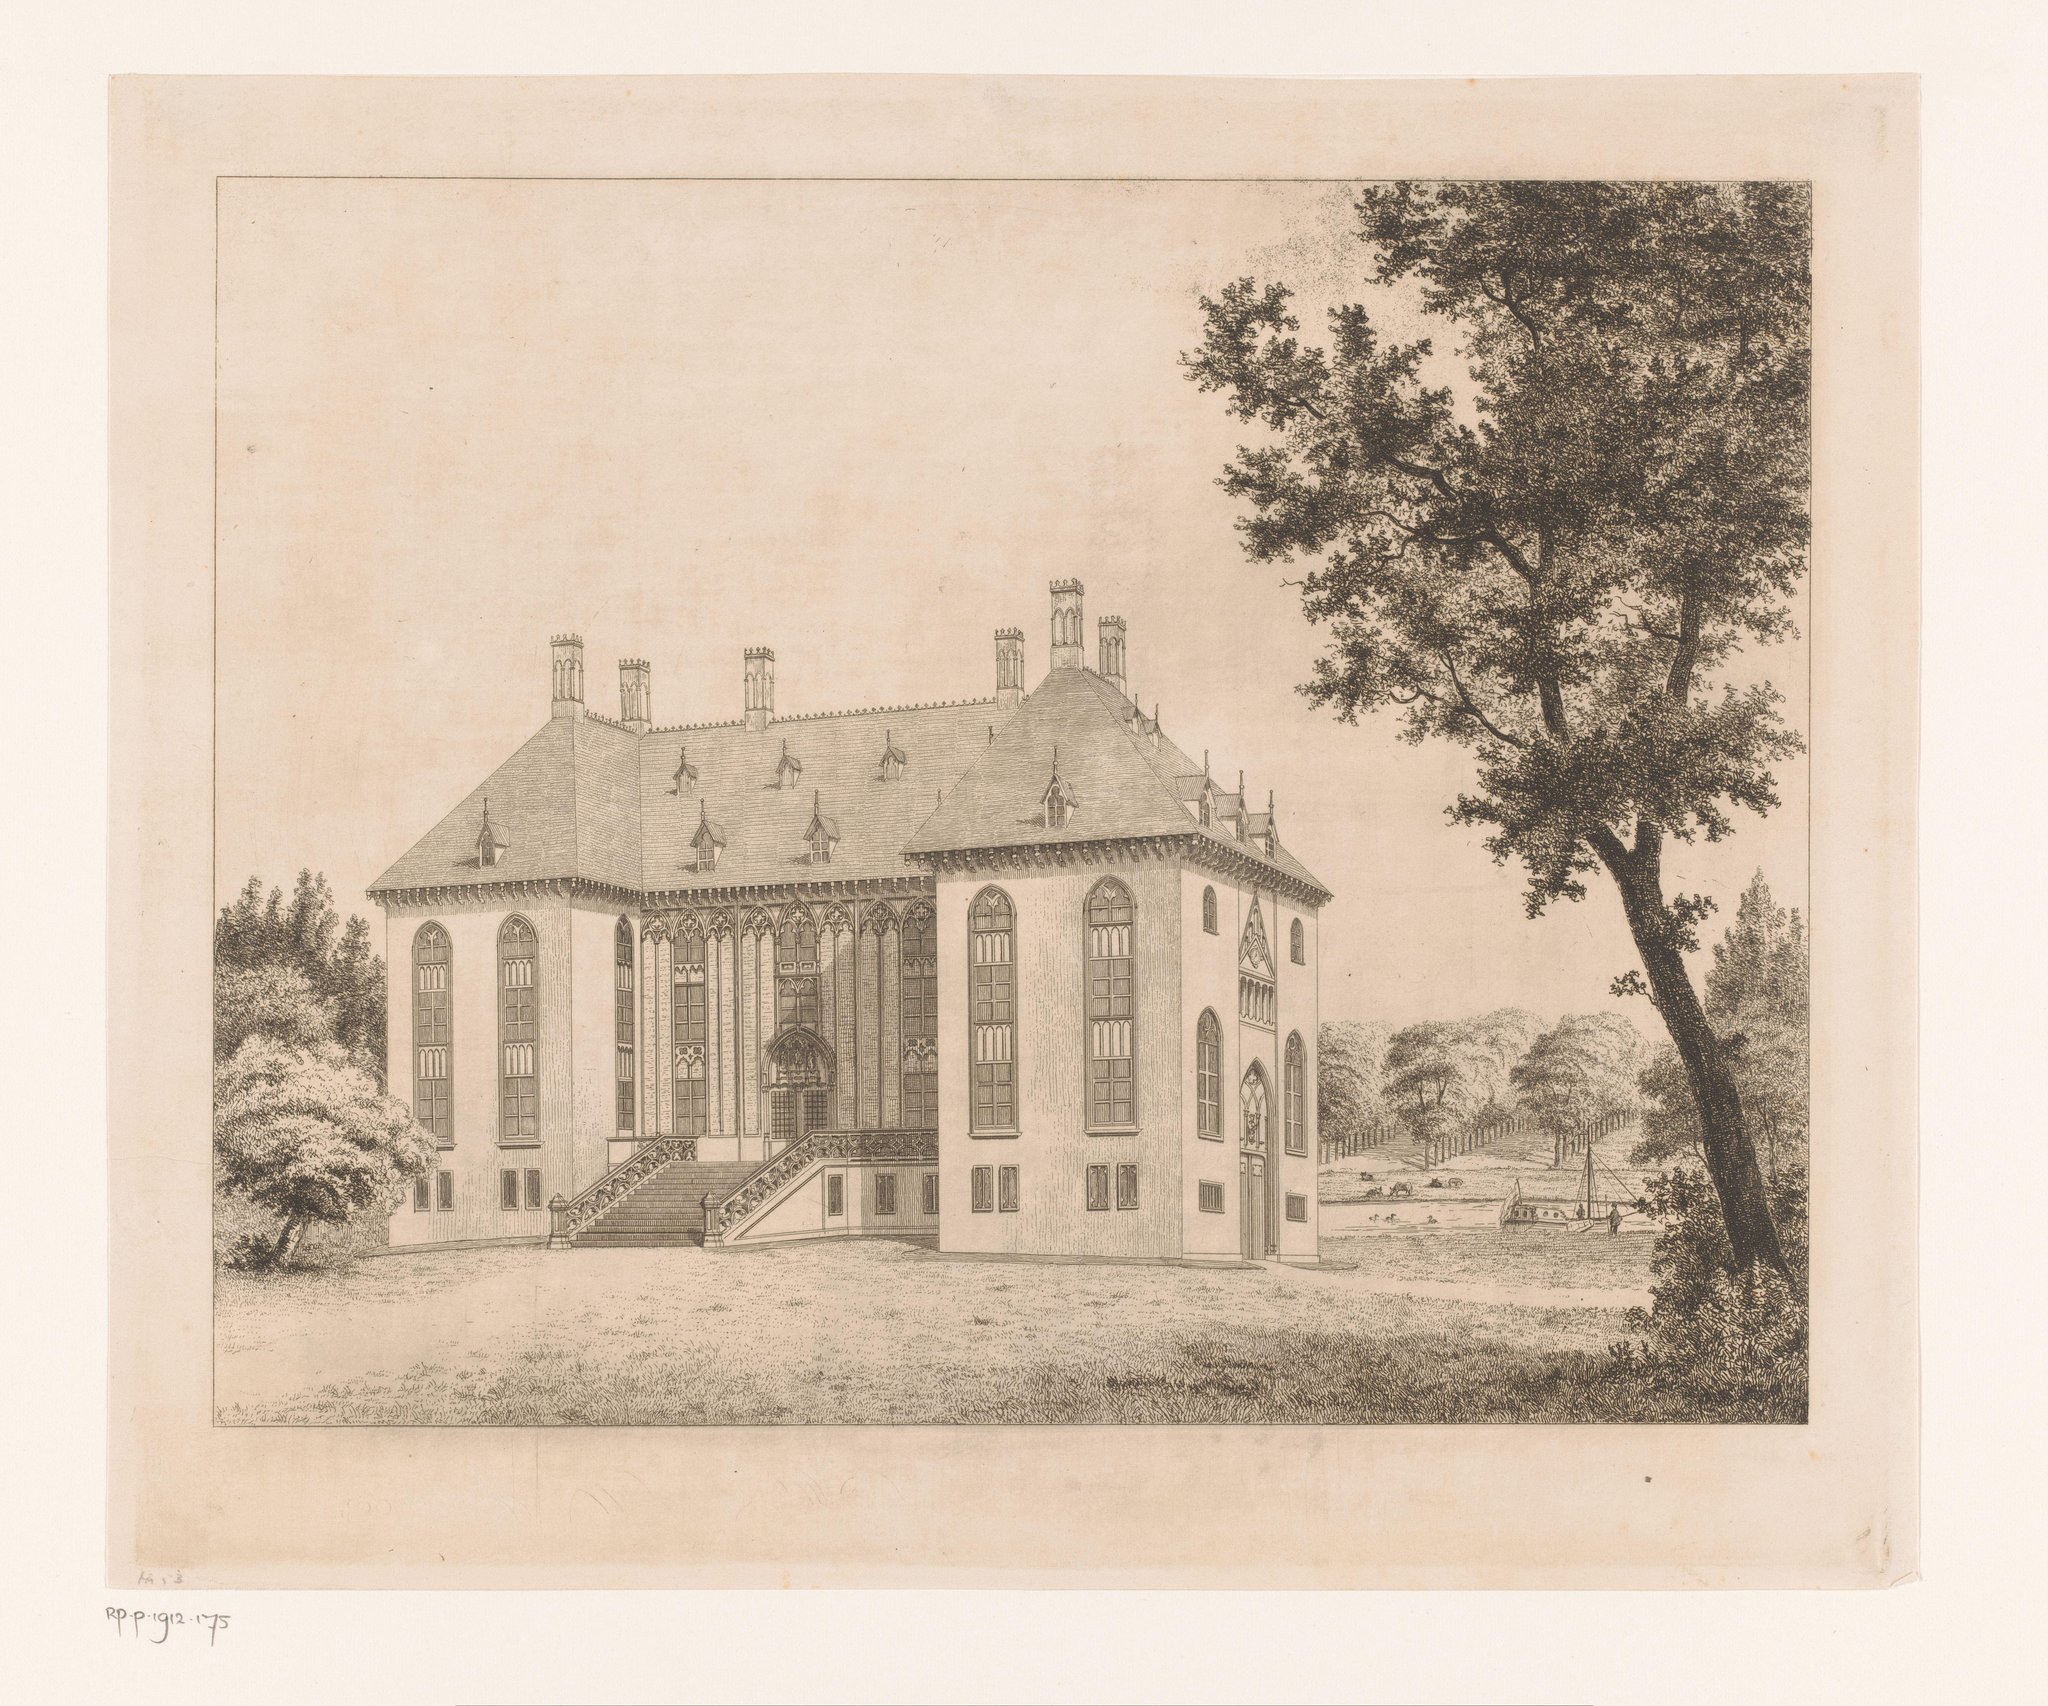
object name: print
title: Kasteel Puttenberg in Beert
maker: jean théodore joseph linnig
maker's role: draughtsman, print maker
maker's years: 1815-1891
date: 1853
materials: paper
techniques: drypoint, etching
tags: castle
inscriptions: collector's mark: Lugt 2228, collector's mark: Lugt 1485